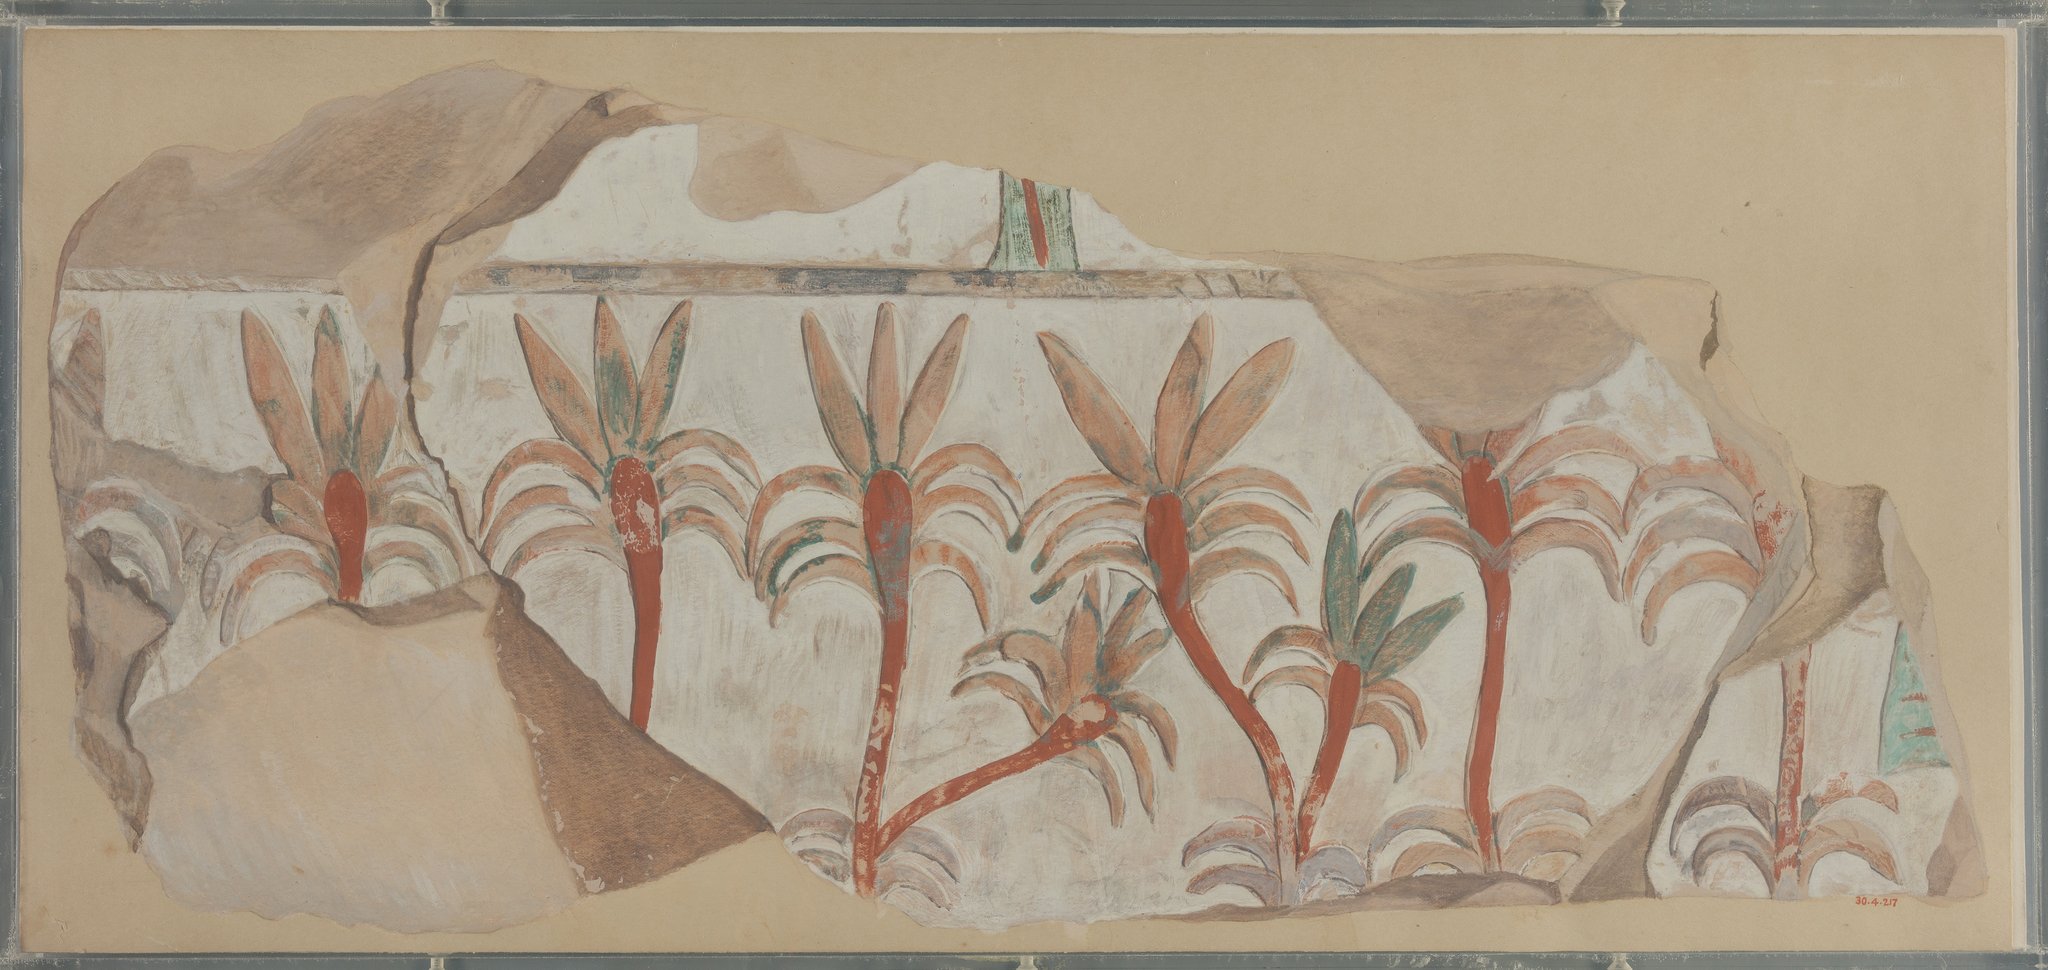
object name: facsimile, puyemre tt 39, palm tree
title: Palm Trees in a Garden, Tomb of Puyemre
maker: norman de garis davies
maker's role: artist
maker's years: 1865-1941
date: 1479-1458 BCE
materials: paper, paint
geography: egypt